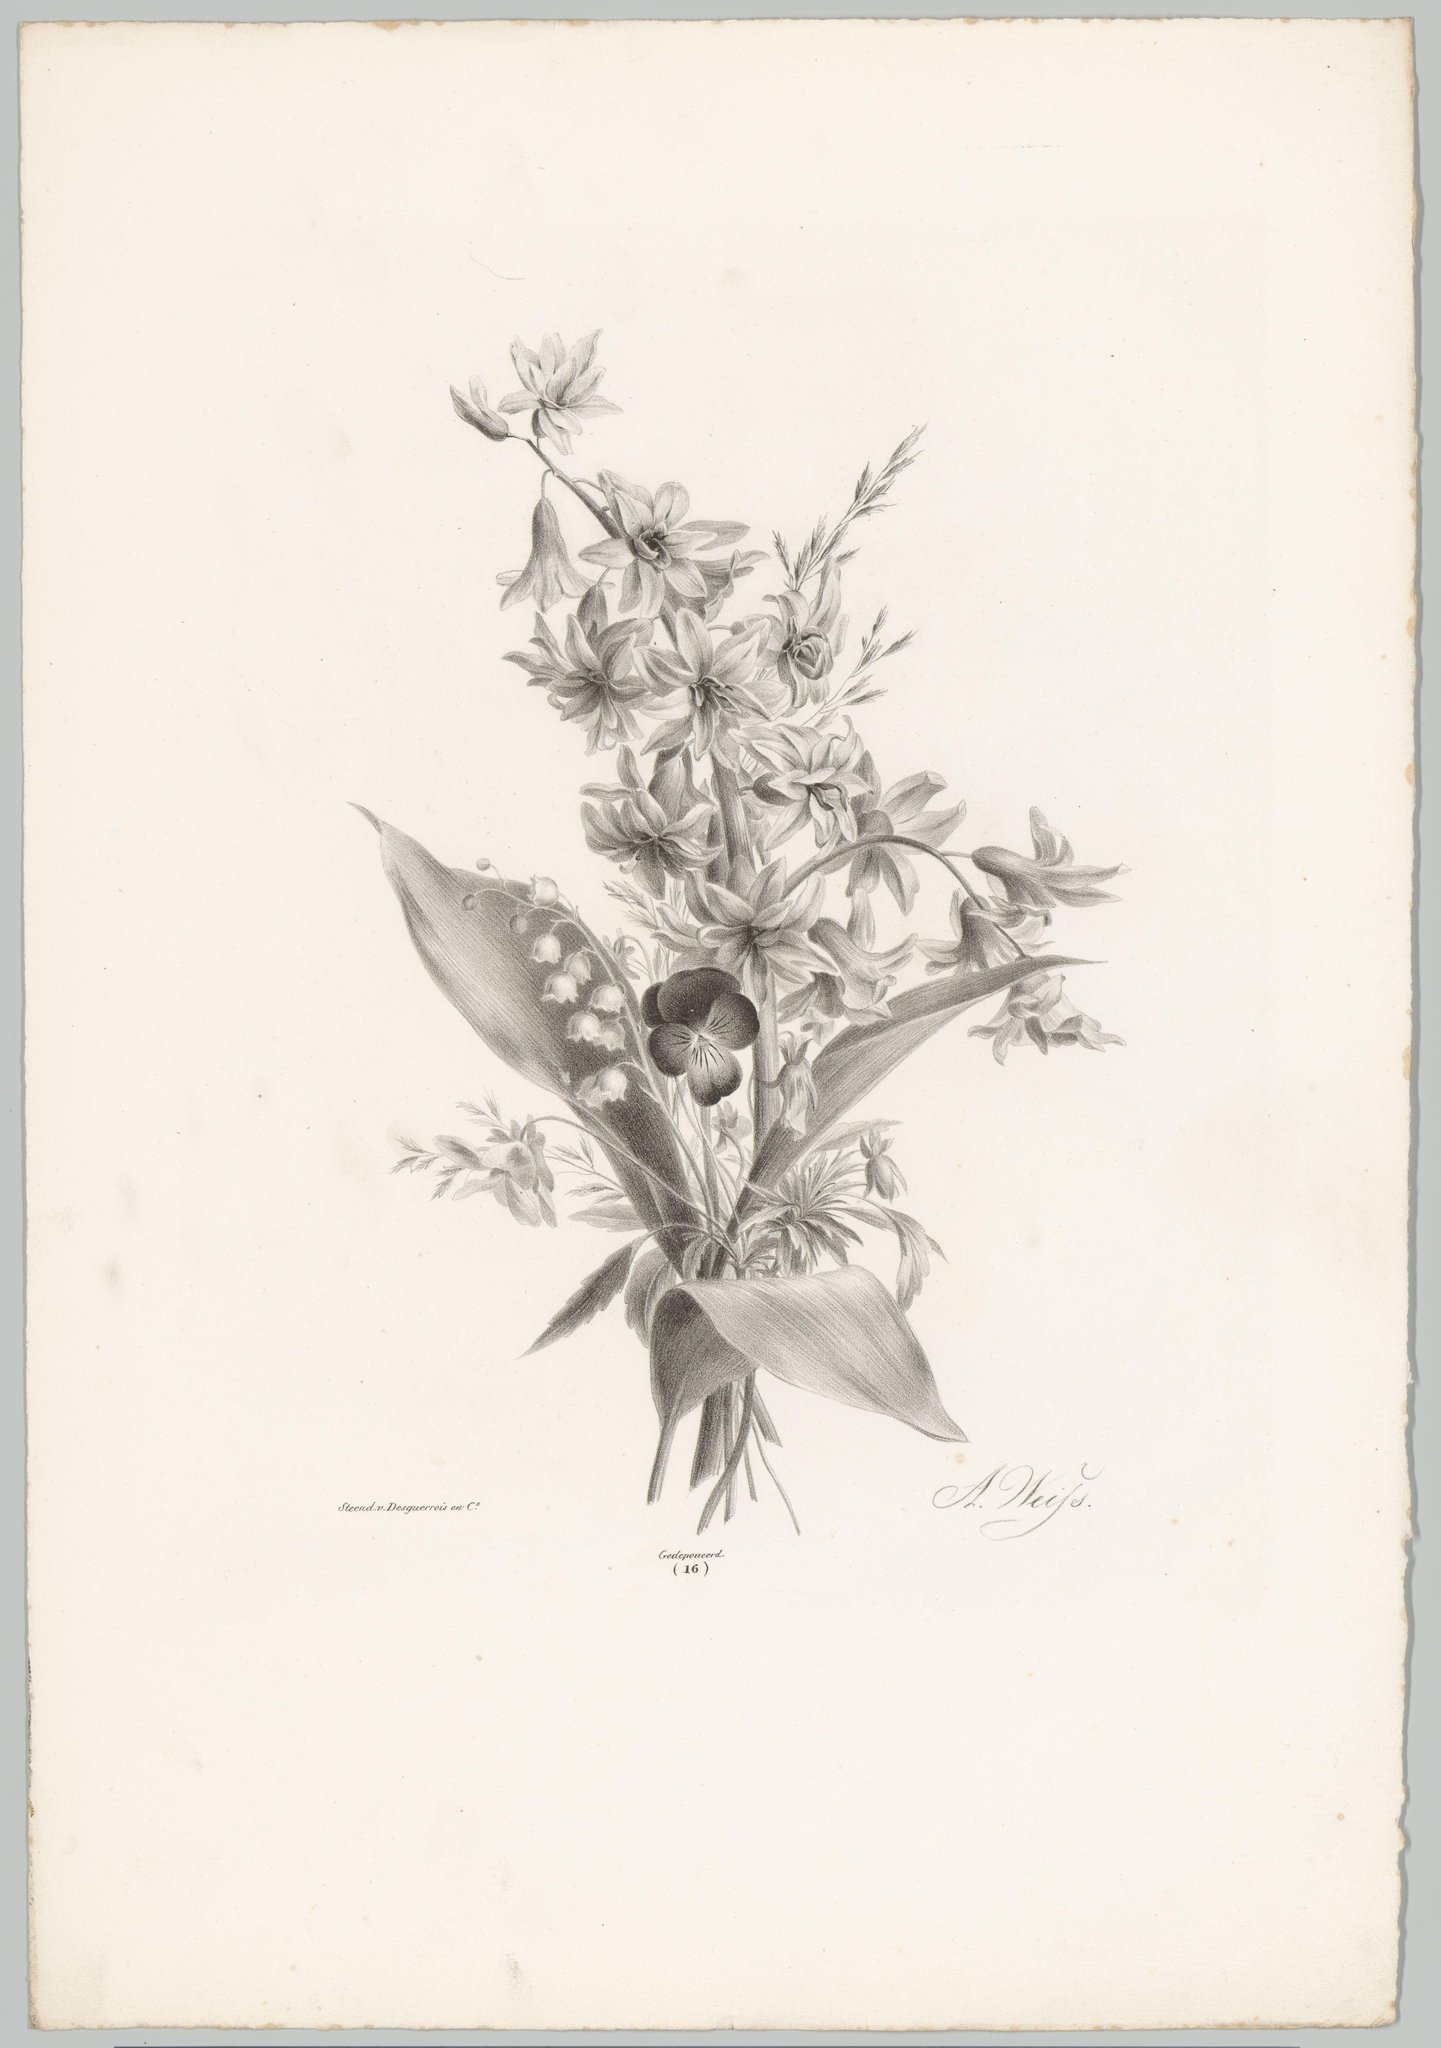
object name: print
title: Bloem en Fruit Studien (...) 10e aflevering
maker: anton weiss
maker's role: draughtsman, print maker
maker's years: 1801-1851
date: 1836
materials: paper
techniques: lithograph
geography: amsterdam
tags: flowers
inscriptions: : ‘Gedeponeerd.’, collector's mark: Lugt 2228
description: Onderdeel van een omslag met een serie van eenenveertig lithografieën van bloemen en fruit.